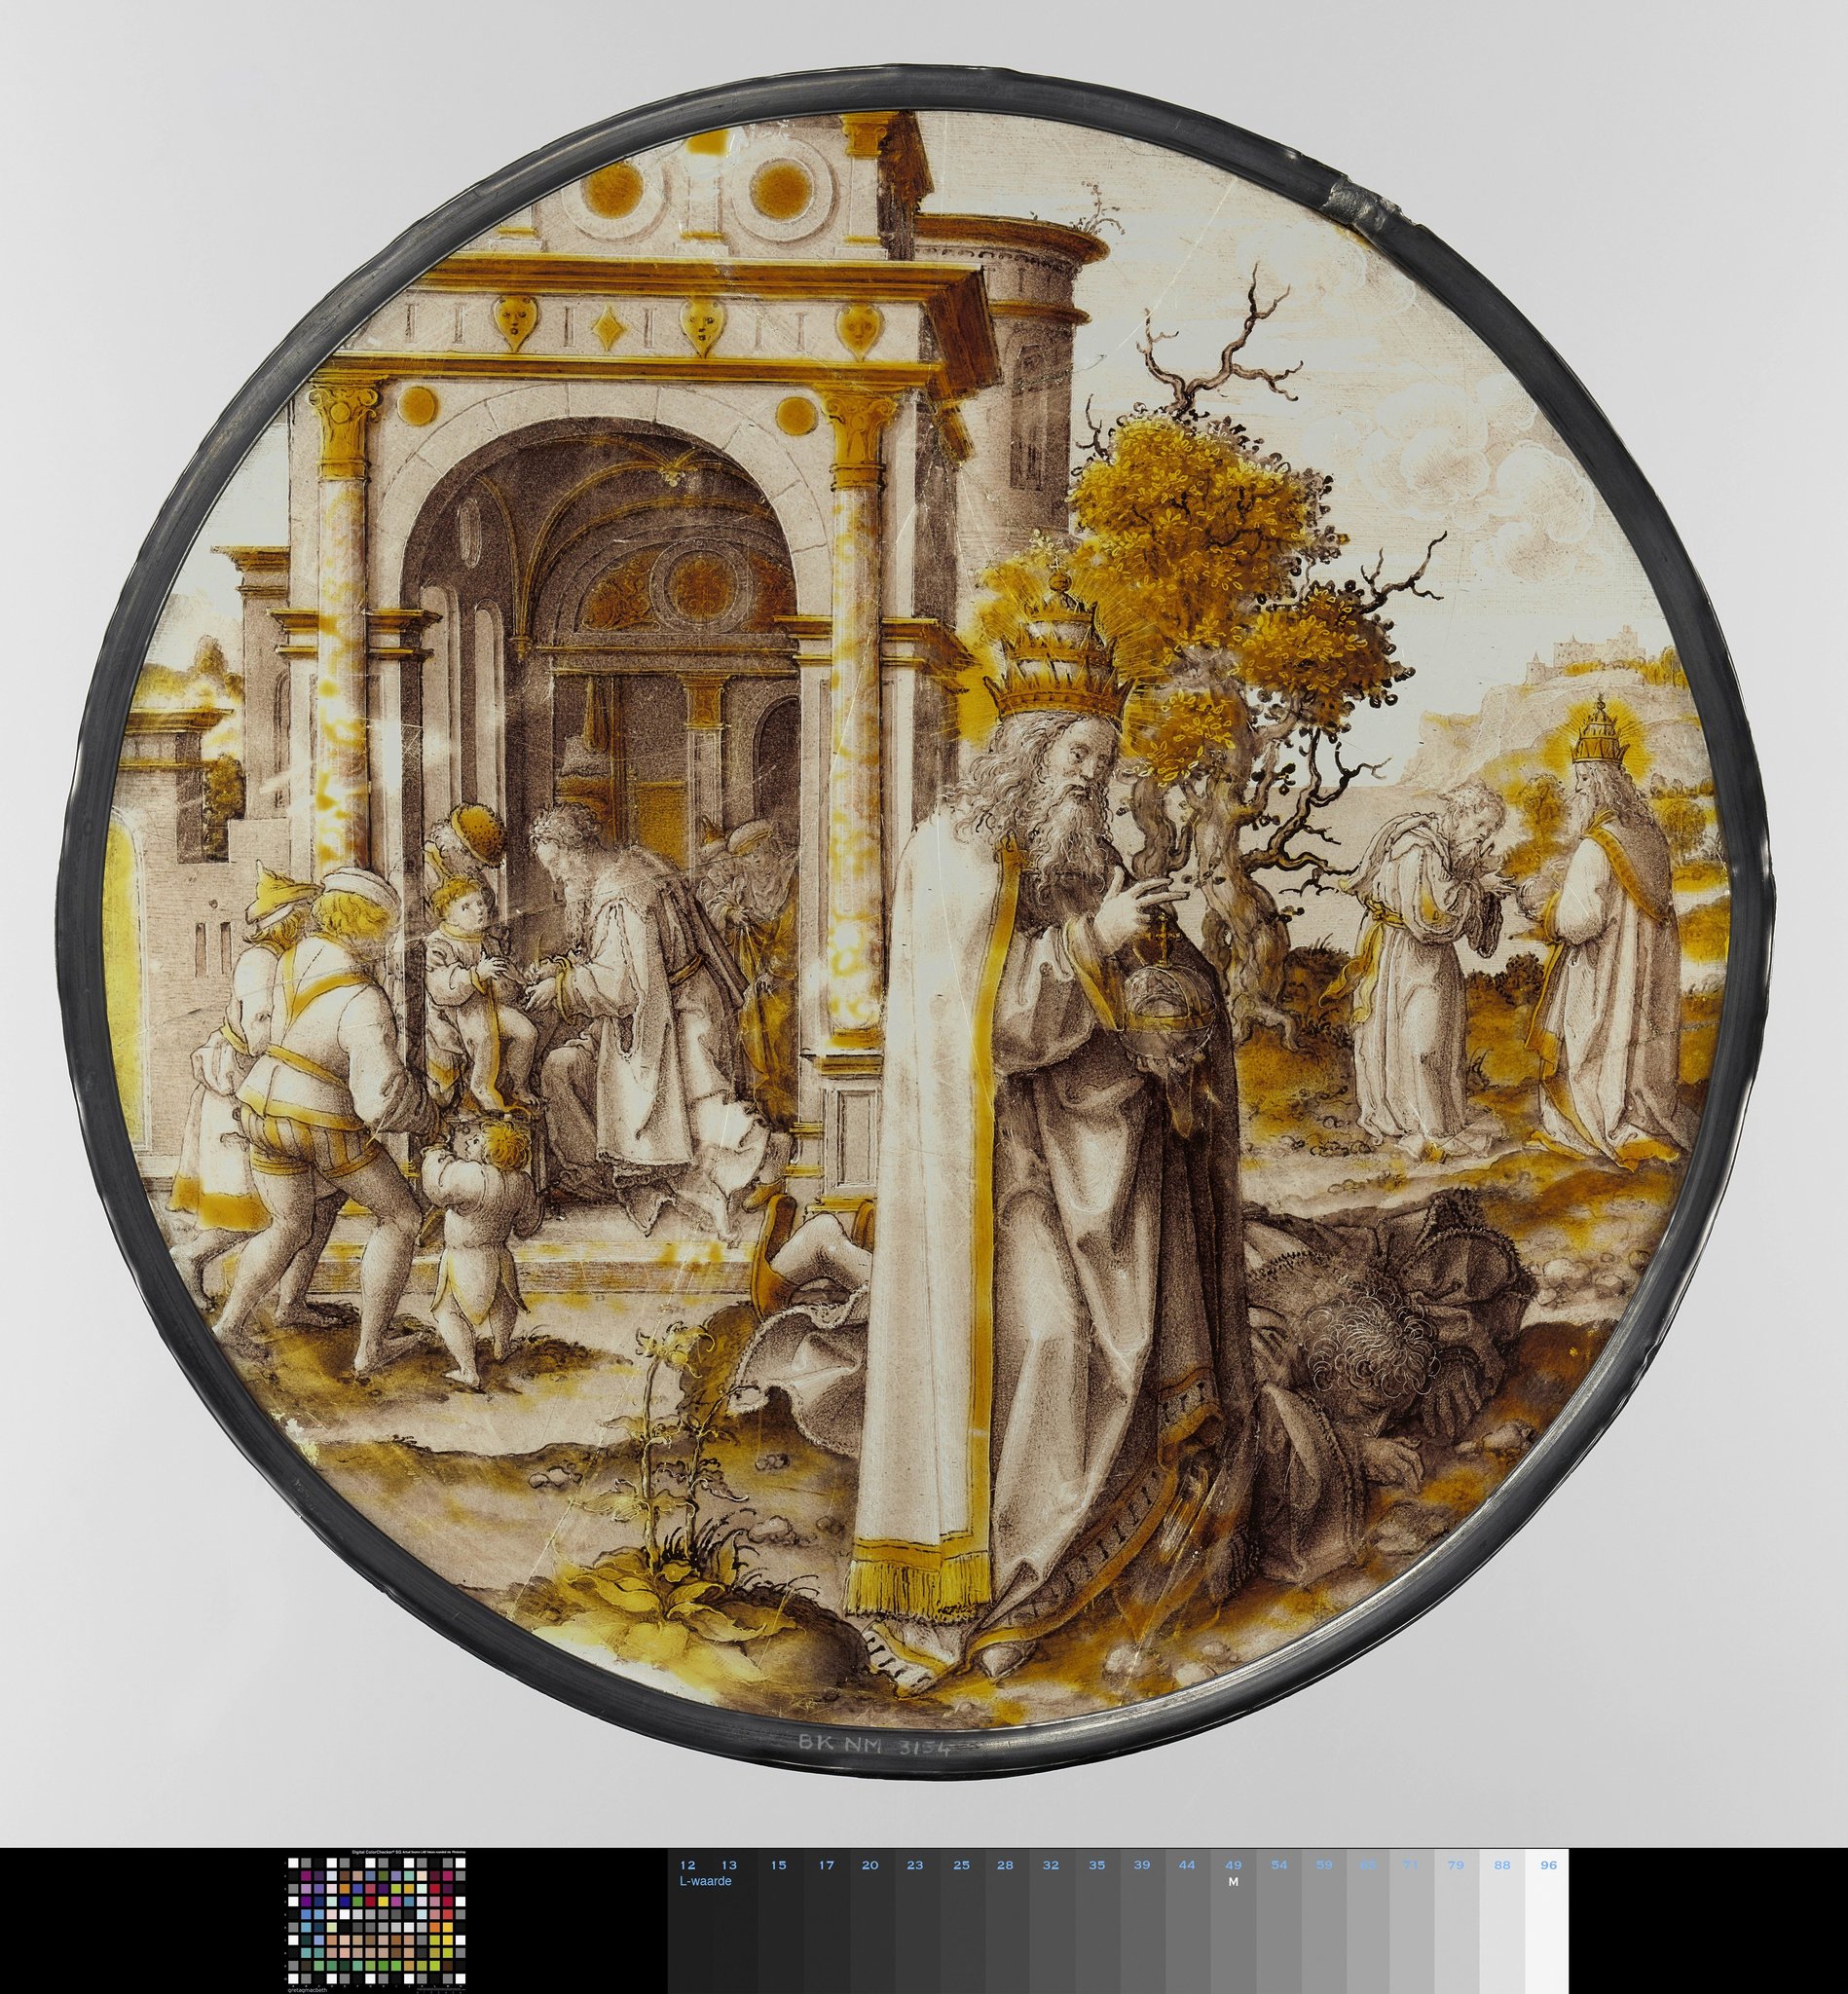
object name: light window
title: Ruit met het verbond tussen God en Abraham, de Verschijning van God aan Abraham en de Besnijdenis van Izaak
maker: dirck vellert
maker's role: draughtsman, painter, print maker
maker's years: 1480-1547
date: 1535-1540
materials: glass, lead, pigment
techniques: leading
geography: antwerp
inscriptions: monogram: ‘D*V’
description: God's Covenant with Abraham, God Appears to Abraham and The Circumcisionof Isaac. Stained glass. Southern Netherlands, 1521, signed by Dirck Vellert (c. 1485 - 1544).